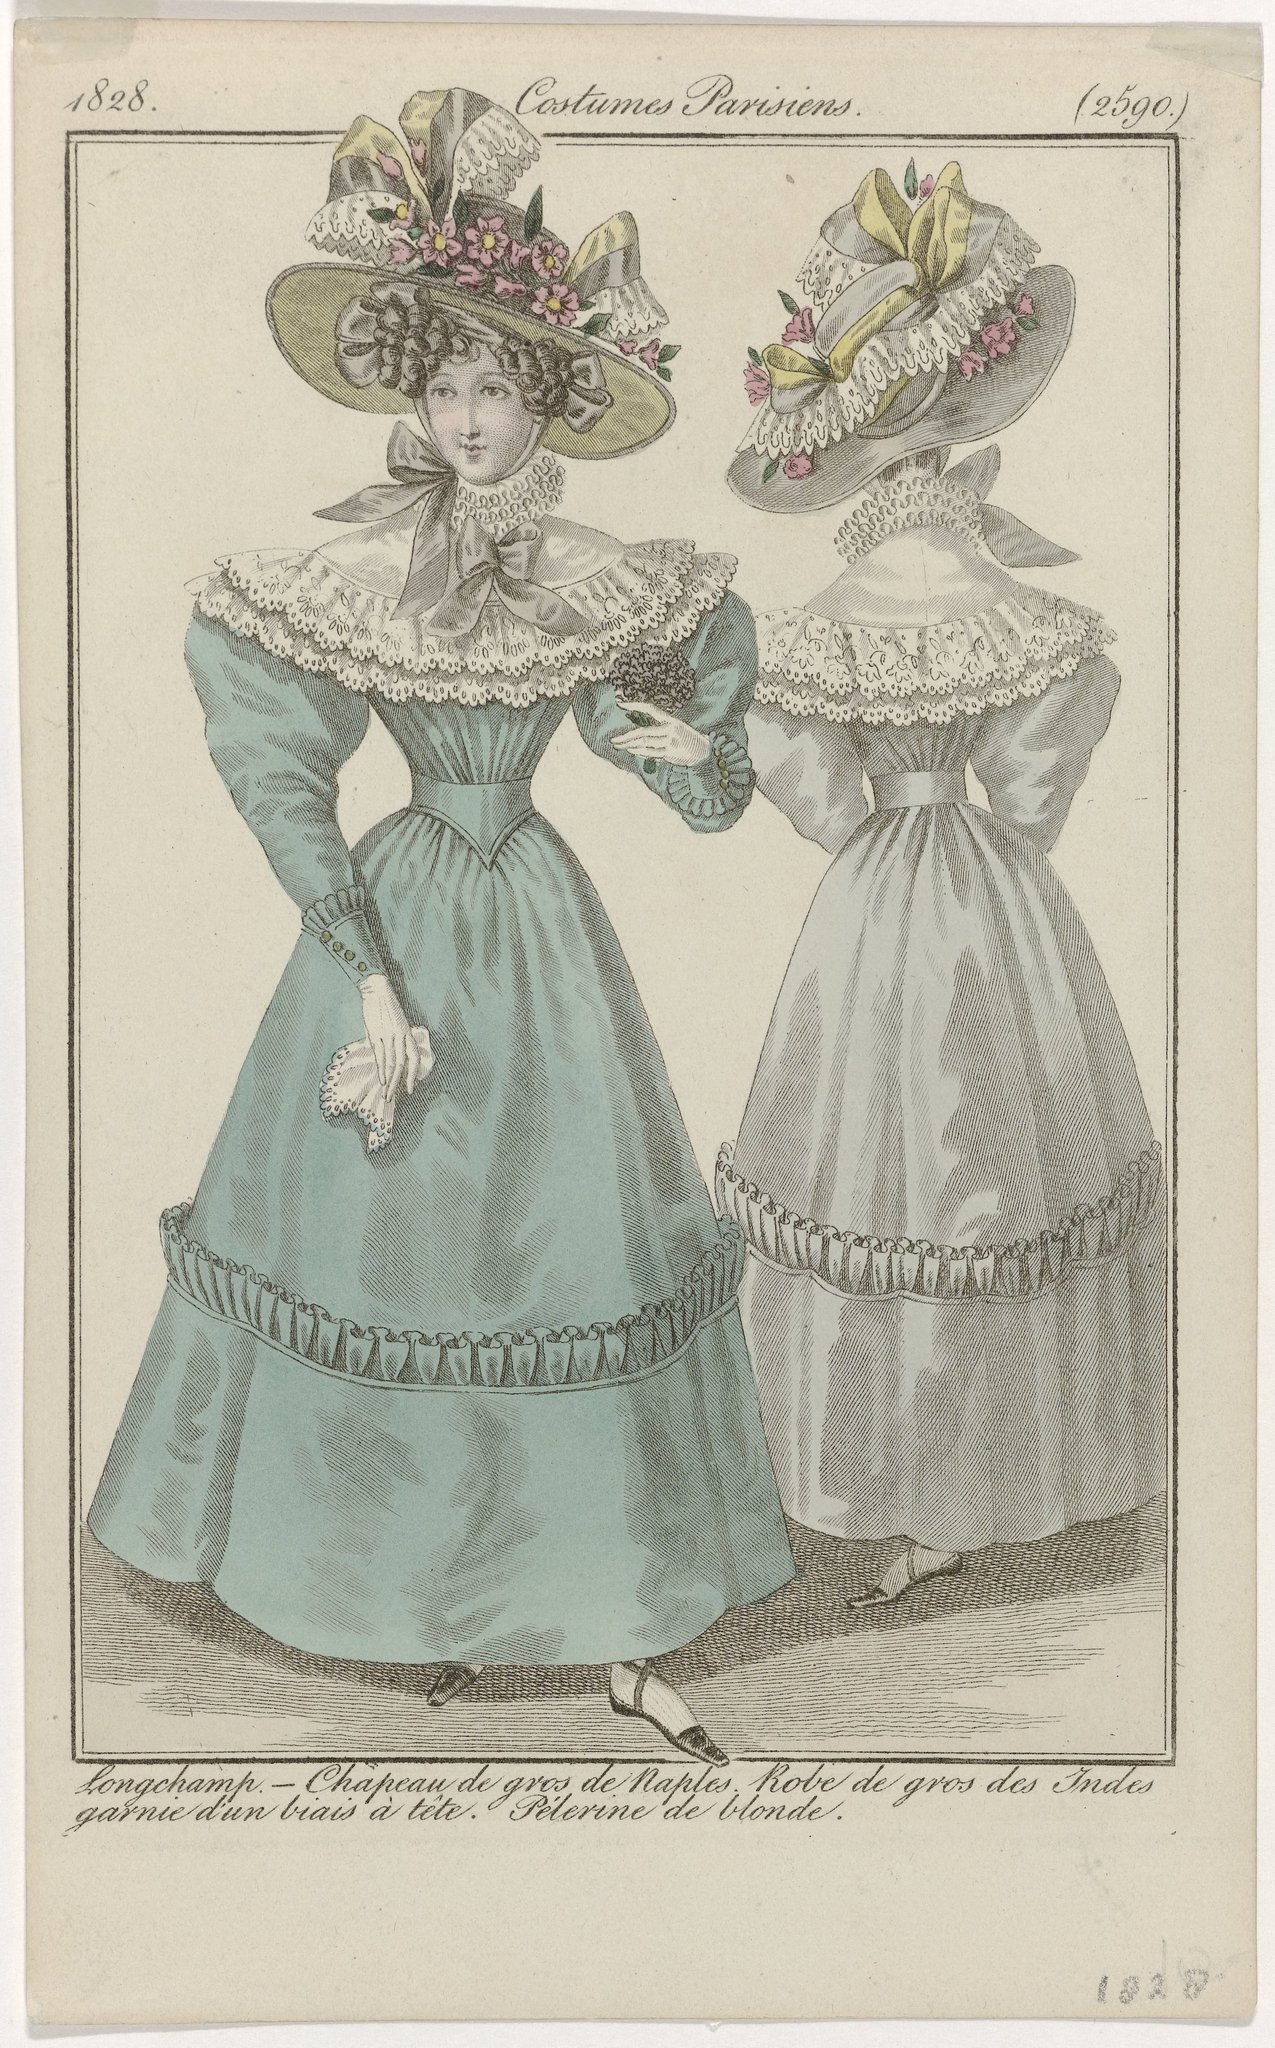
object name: fashion print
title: Journal des Dames et des Modes, Costumes Parisiens, 15 avril 1828, (2590): Longchamp (...)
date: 1828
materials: paper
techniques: engraving, hand coloring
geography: paris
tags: handkerchief (+ women's clothes), cut flowers; nosegay, bunch of flowers, ornamental parts of clothing (+ women's clothes), clothing for the upper part of the body (pelerine) (+ women's clothes), lace (+ women's clothes), clothing for the upper part of the body (pelerine) (+ lace used for clothes), fashion plates, clothes, costume (+ women's clothes), head-gear: hat (+ women's clothes), shoes, sandals (+ women's clothes), gloves, mittens, etc. (+ women's clothes), dress, gown (+ women's clothes)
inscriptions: title: ‘Costumes Parisiens.’, caption: ‘Longchamp. Chapeau de gros de Naples. Robe de gros de Indes garnie d'un biais à tête. Pélerine de blonde.’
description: 'Longchamp.' Vrouw met op het hoofd een hoed van 'gros de Naples'. Zij draagt een japon van 'gros de Indes', versierd met een biaisband. Schapenboutmouwen. Pelerine van Blonde (kloskant). Verdere accessoires: handschoenen, zakdoek, platte schoenen met gekruiste banden. De prent maakt deel uit van het modetijdschrift Journal des Dames et des Modes, uitgegeven door Pierre de la Mésangère, Parijs, 1797-1839.